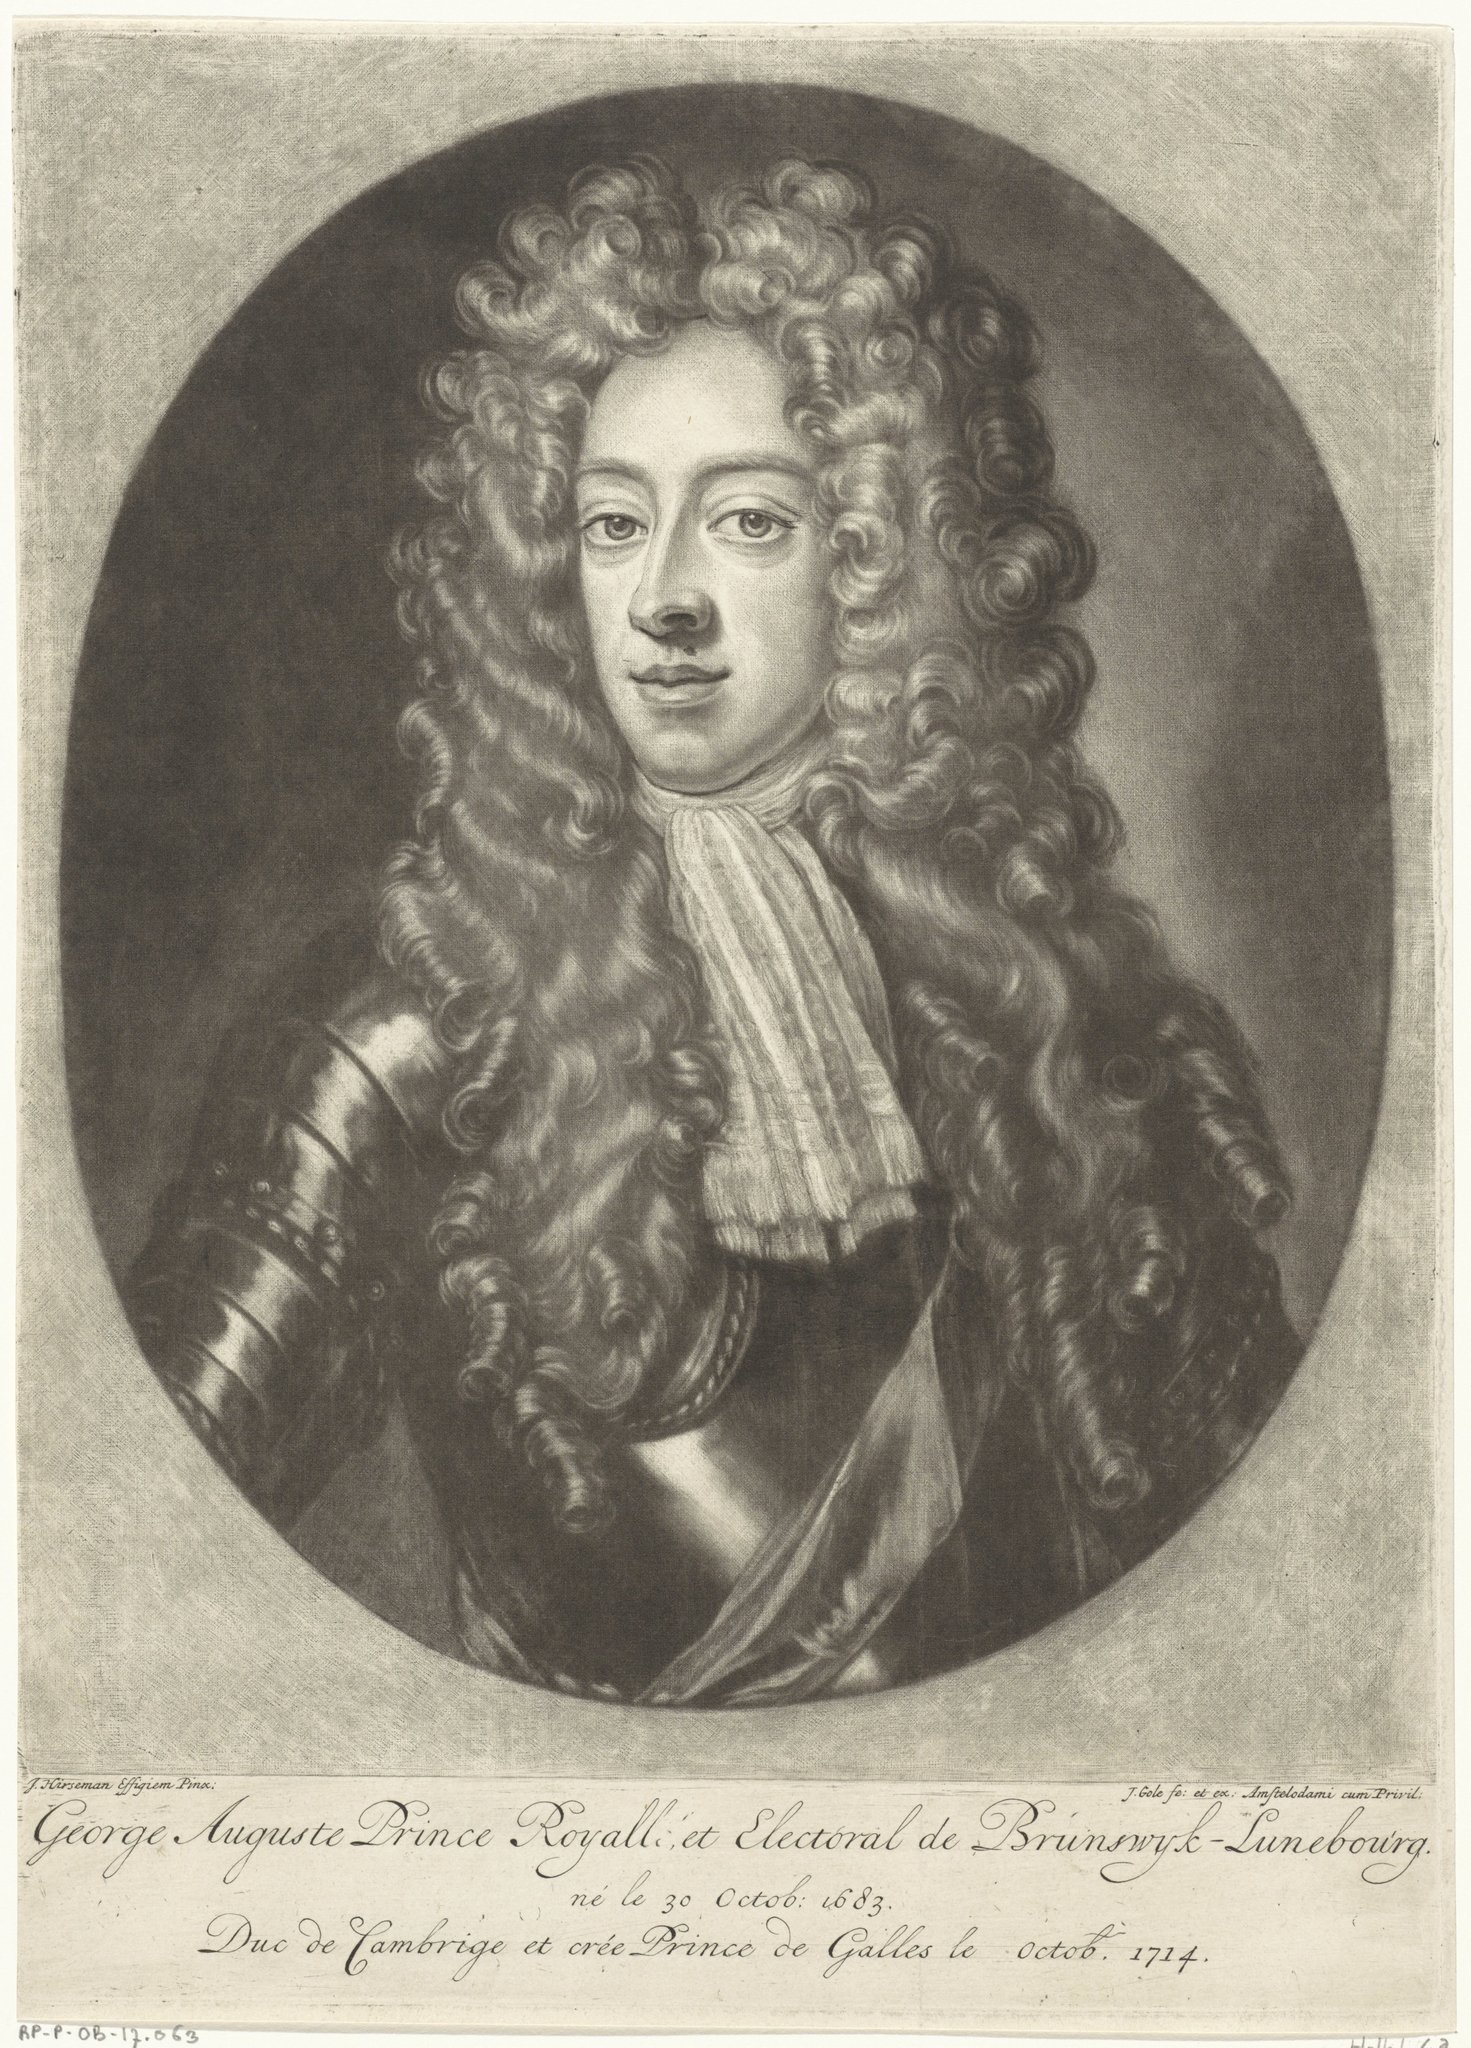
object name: print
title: Portret van George II Augustus van Groot-Brittannië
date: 1714-1724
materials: paper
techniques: engraving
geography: amsterdam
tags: london, george ii augustus (koning van groot-brittannië), harness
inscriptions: collector's mark: Lugt 2228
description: George II Augustus van Hannover, koning van Groot-Brittannië. Hij draagt een harnas en een kraag van kant.